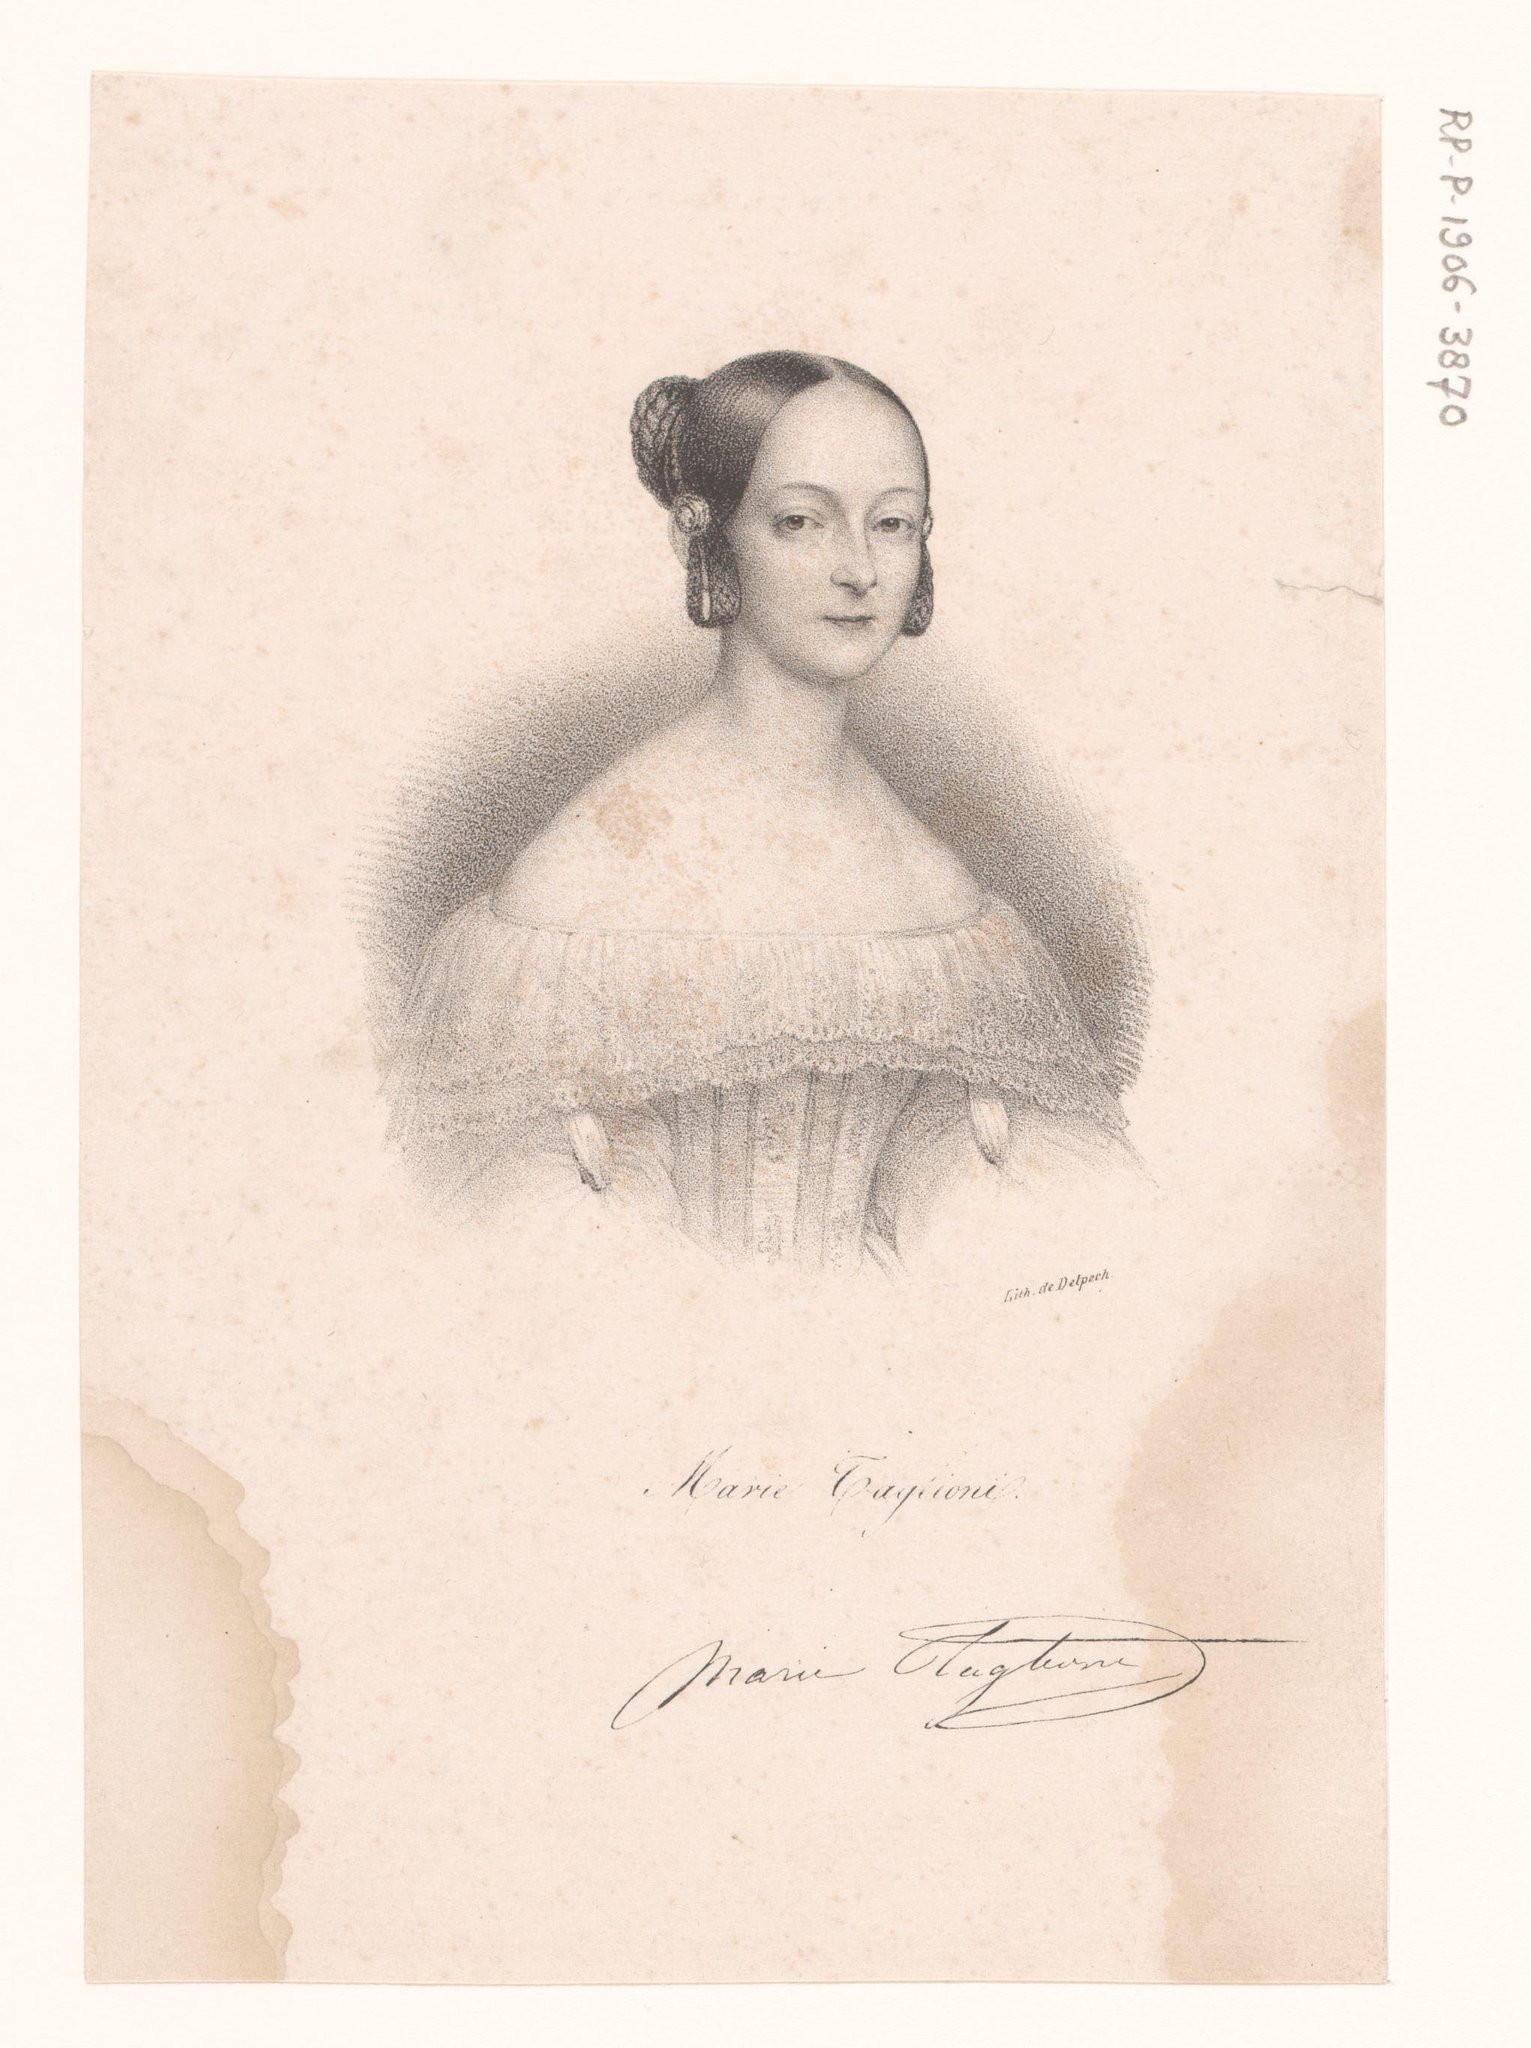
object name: print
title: Portret van Marie Taglioni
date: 1818-1842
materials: paper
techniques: lithograph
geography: paris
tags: historical persons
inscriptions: collector's mark: Lugt 2228a